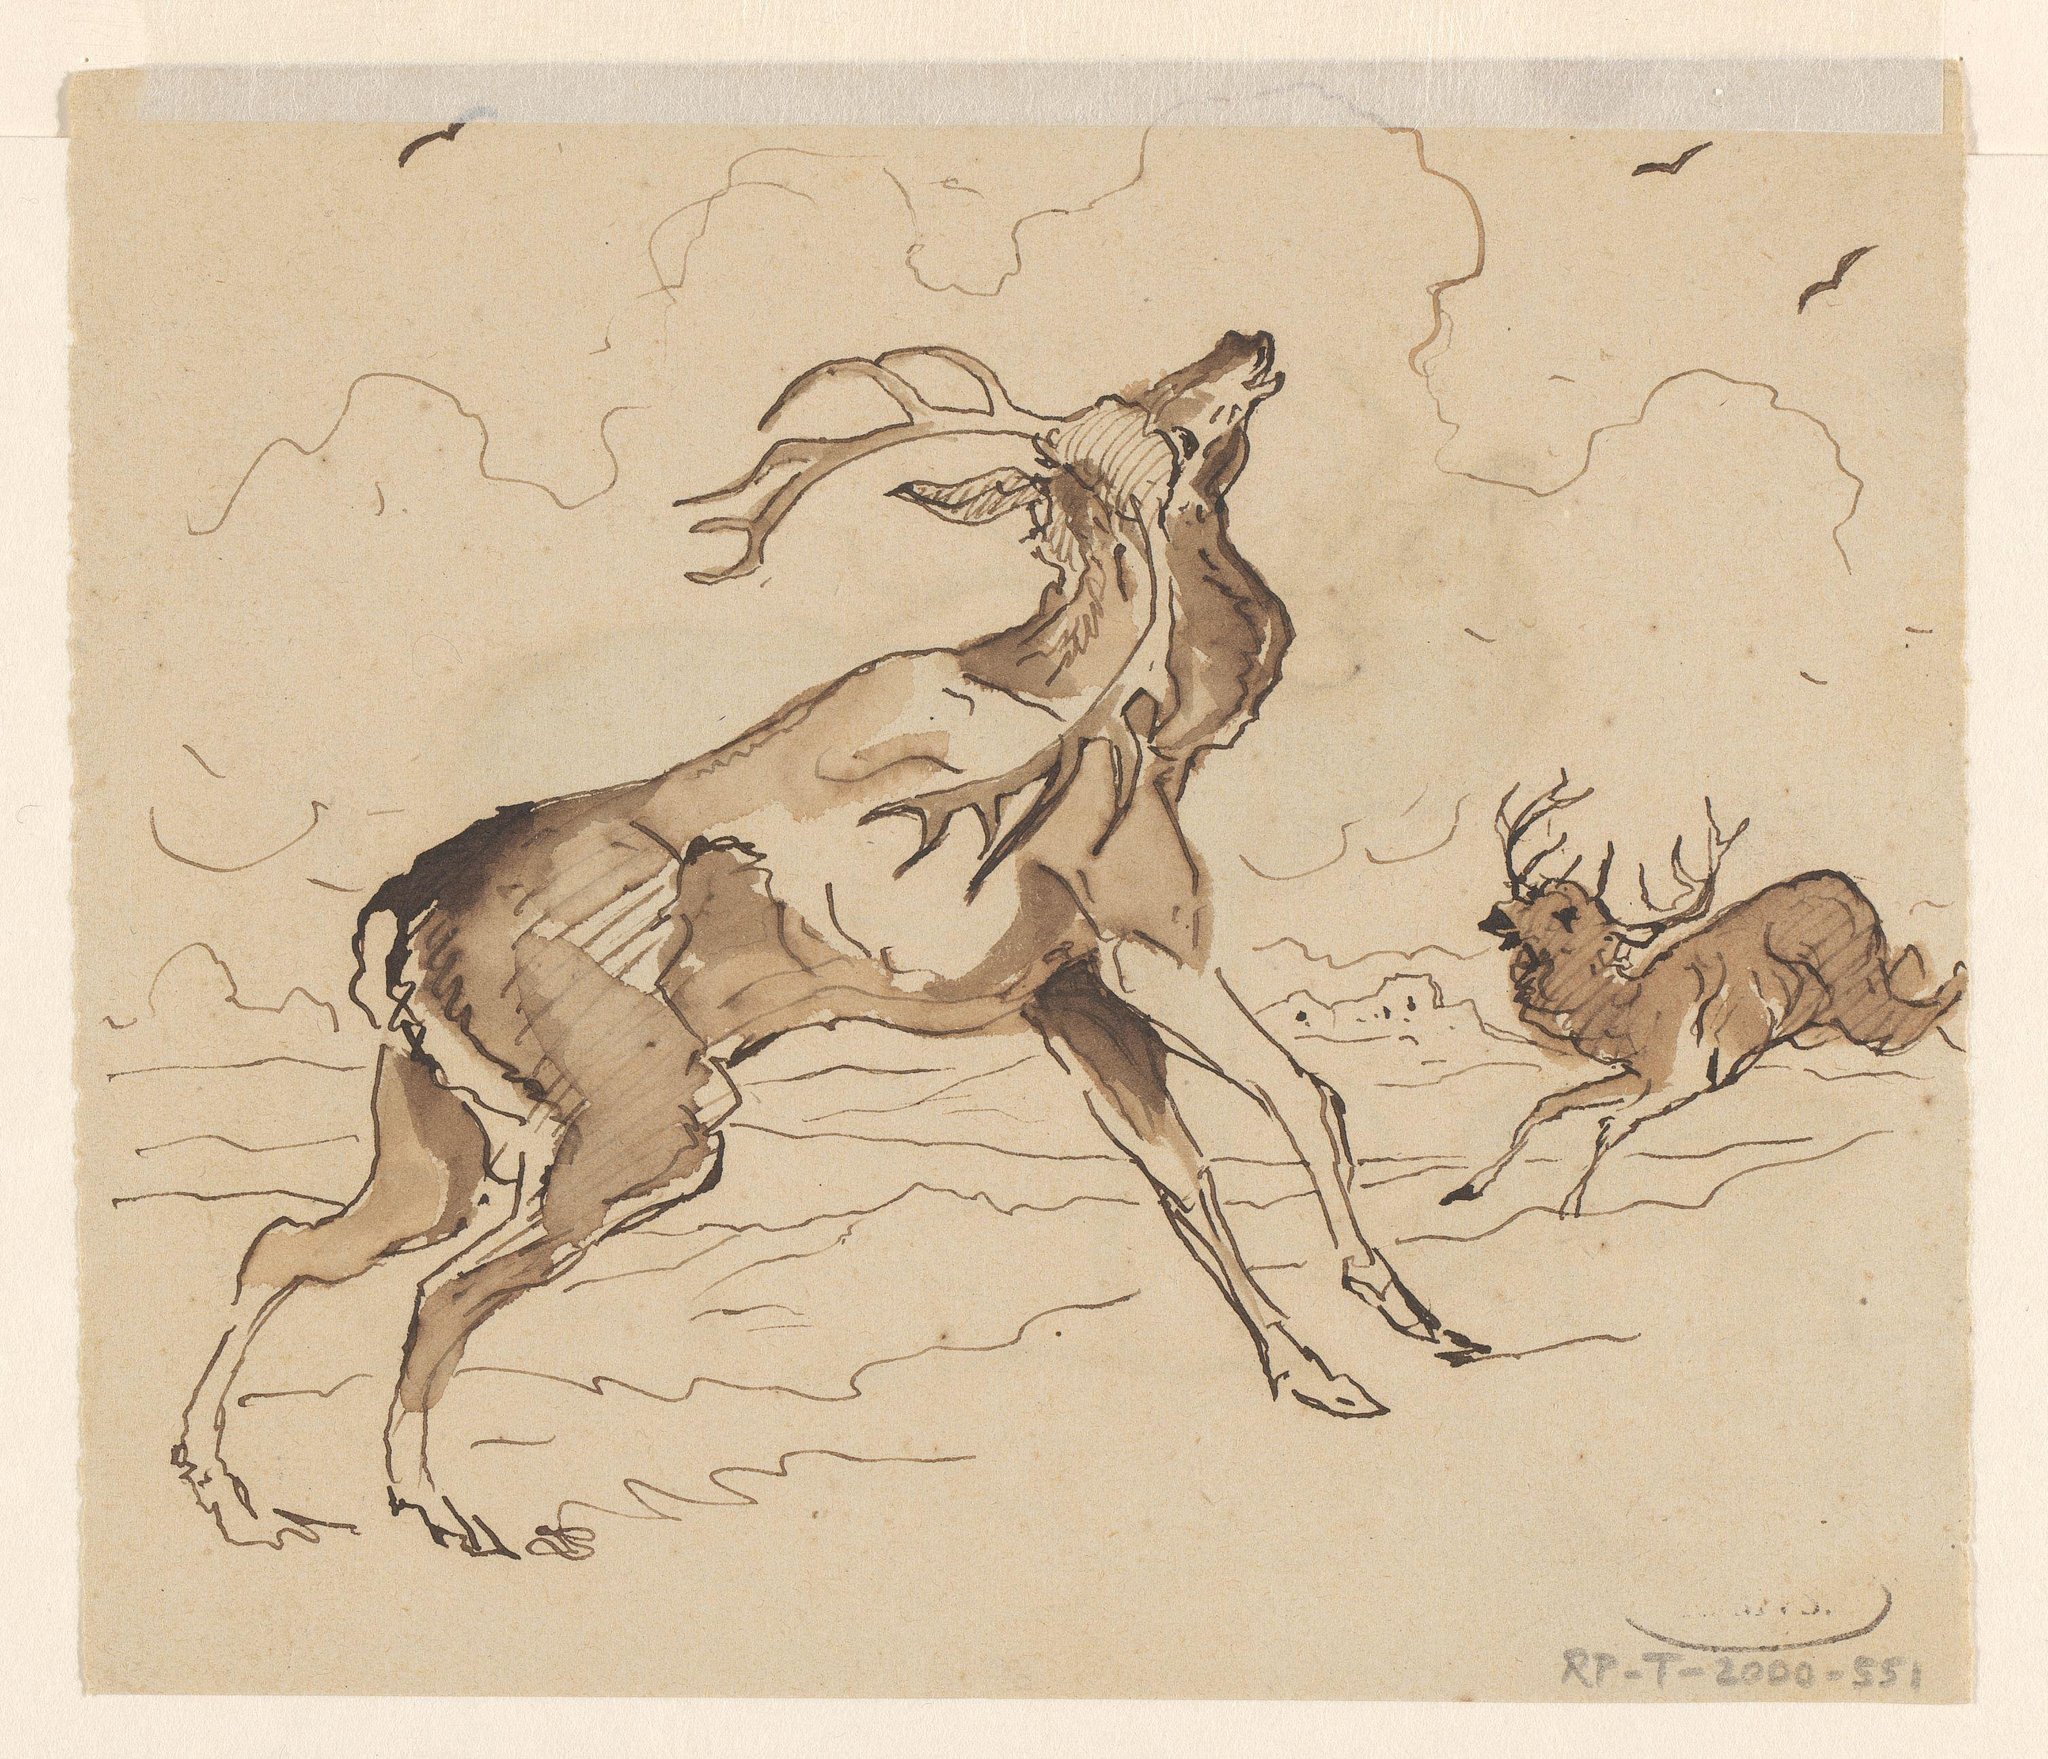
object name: drawing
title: Twee herten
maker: johannes tavenraat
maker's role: draughtsman, painter, print maker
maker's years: 1809-1881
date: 1840-1880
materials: ink, paper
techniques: brush, pen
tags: hoofed animals: deer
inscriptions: collector's mark: Lugt 2228